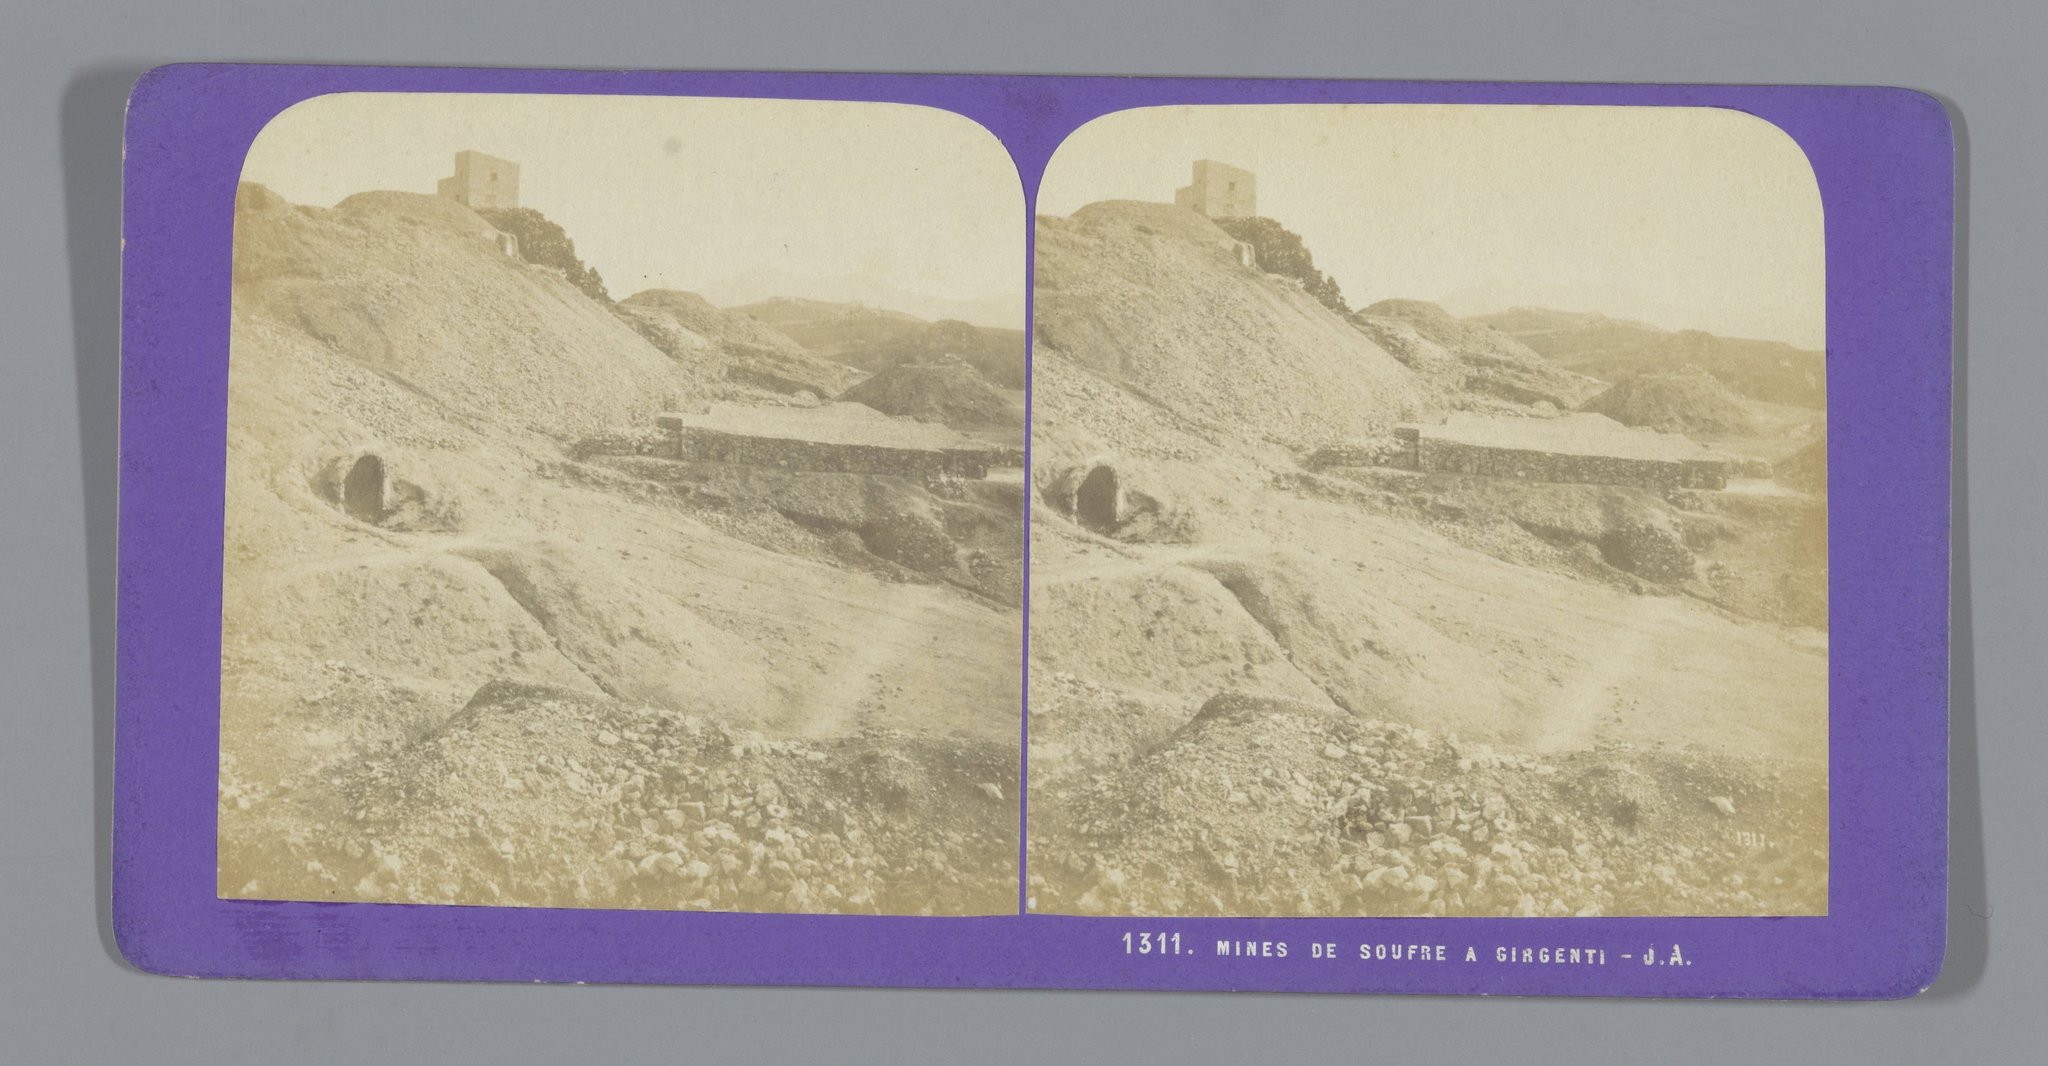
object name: stereograph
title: Mines de Soufre a Girgenti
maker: jean andrieu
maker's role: fotograaf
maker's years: 1816-1872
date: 1862-1876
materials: cardboard, paper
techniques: albumen print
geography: agrigento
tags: mining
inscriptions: number: ‘1311’